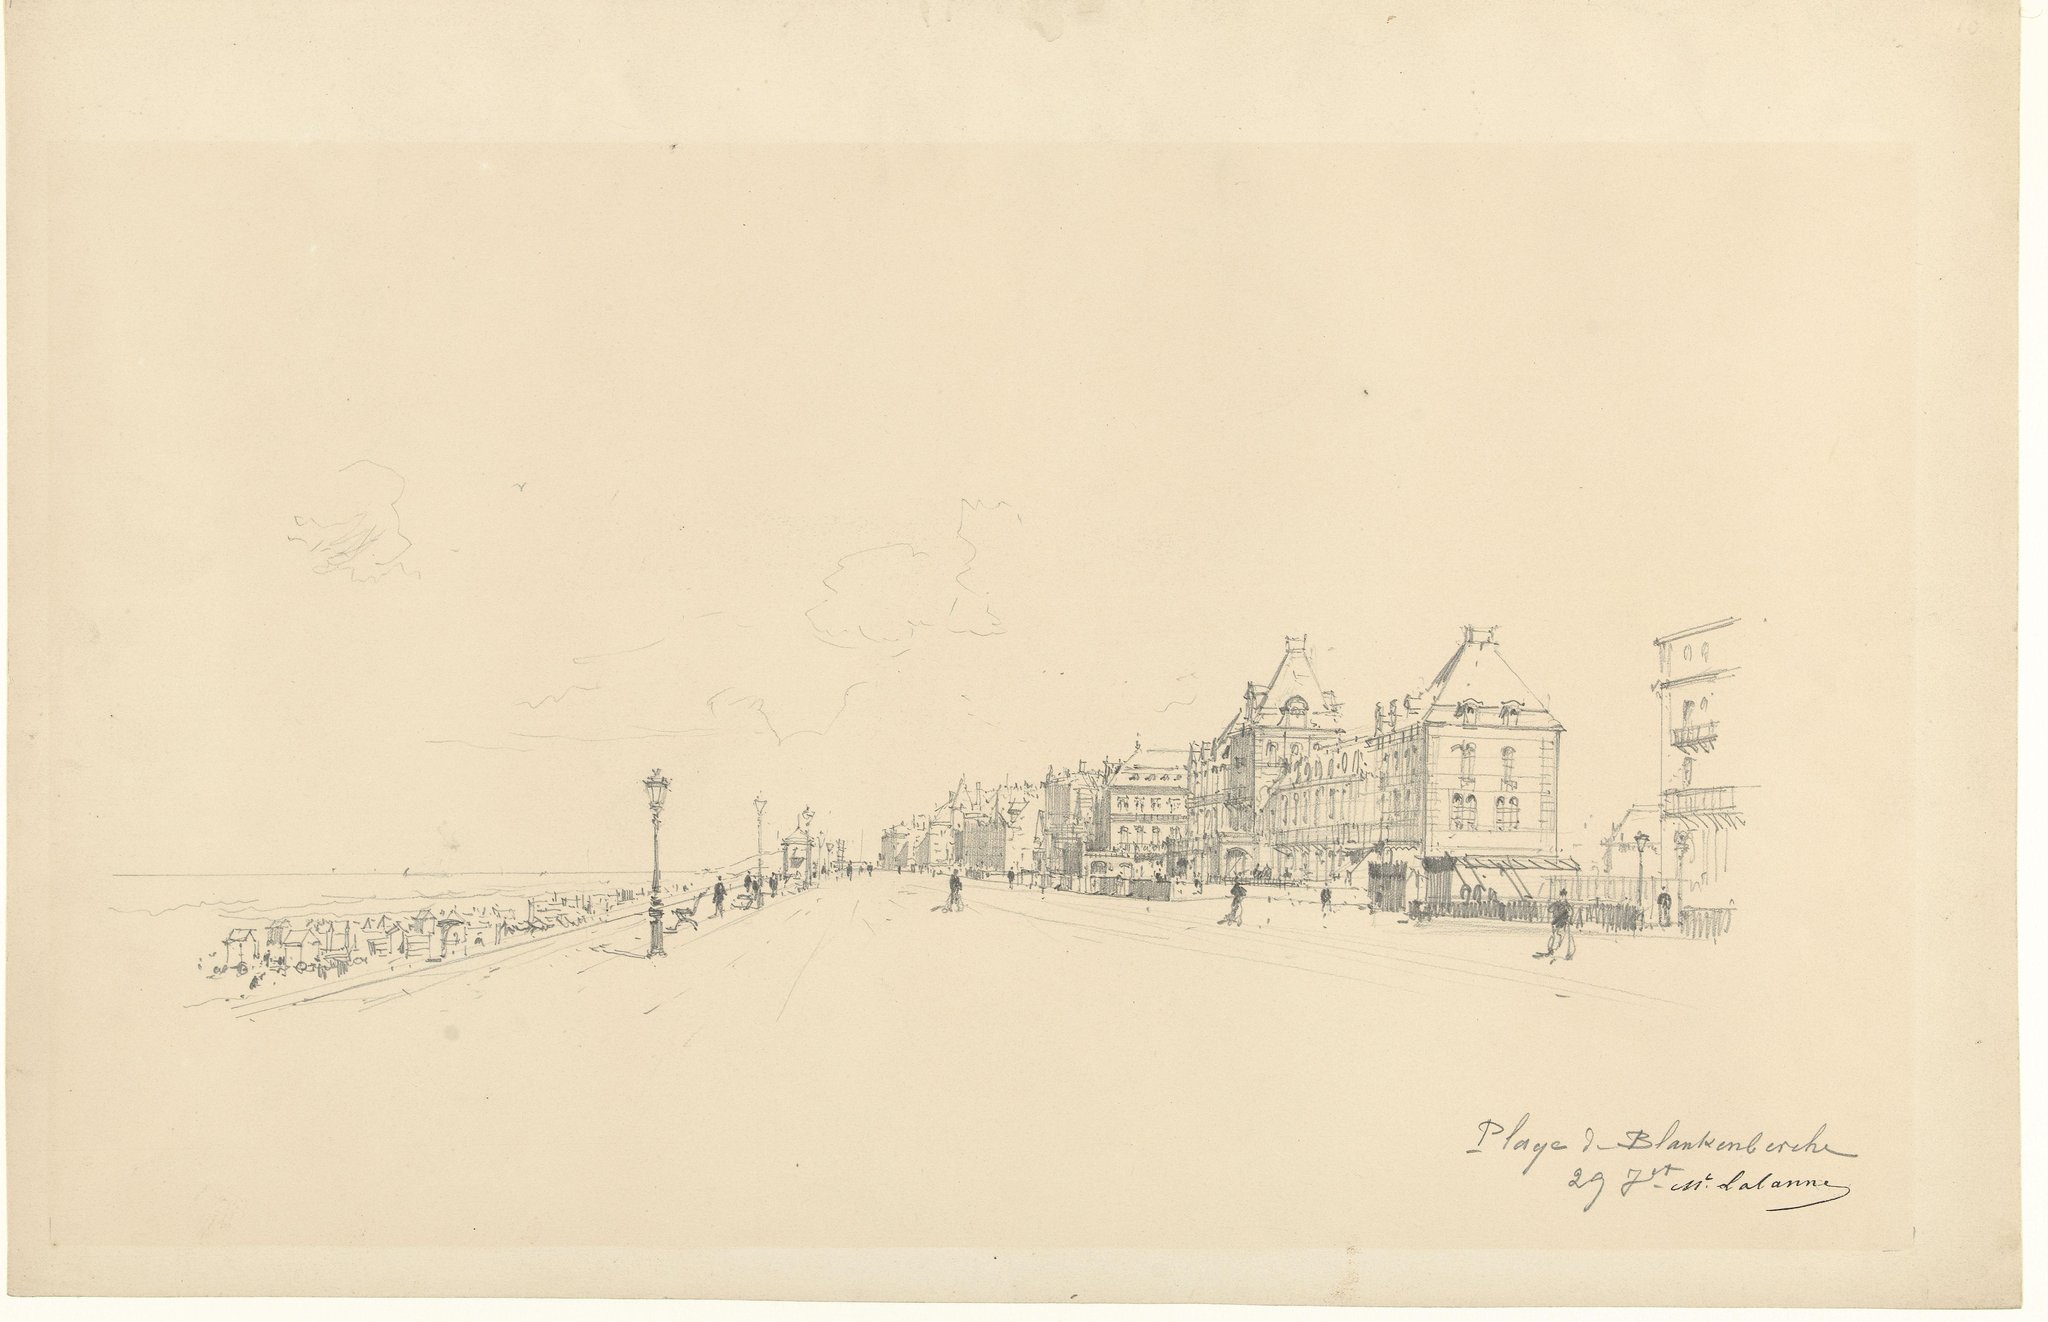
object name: drawing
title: Boulevard en strand te Blankenberge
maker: maxime françois antoine lalanne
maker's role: draughtsman, print maker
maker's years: 1827-1886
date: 1837-1886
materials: paper, pencil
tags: beach (as place of recreation), avenue, boulevard, promenade, esplanade (+ city(-scape) with figures, staffage)